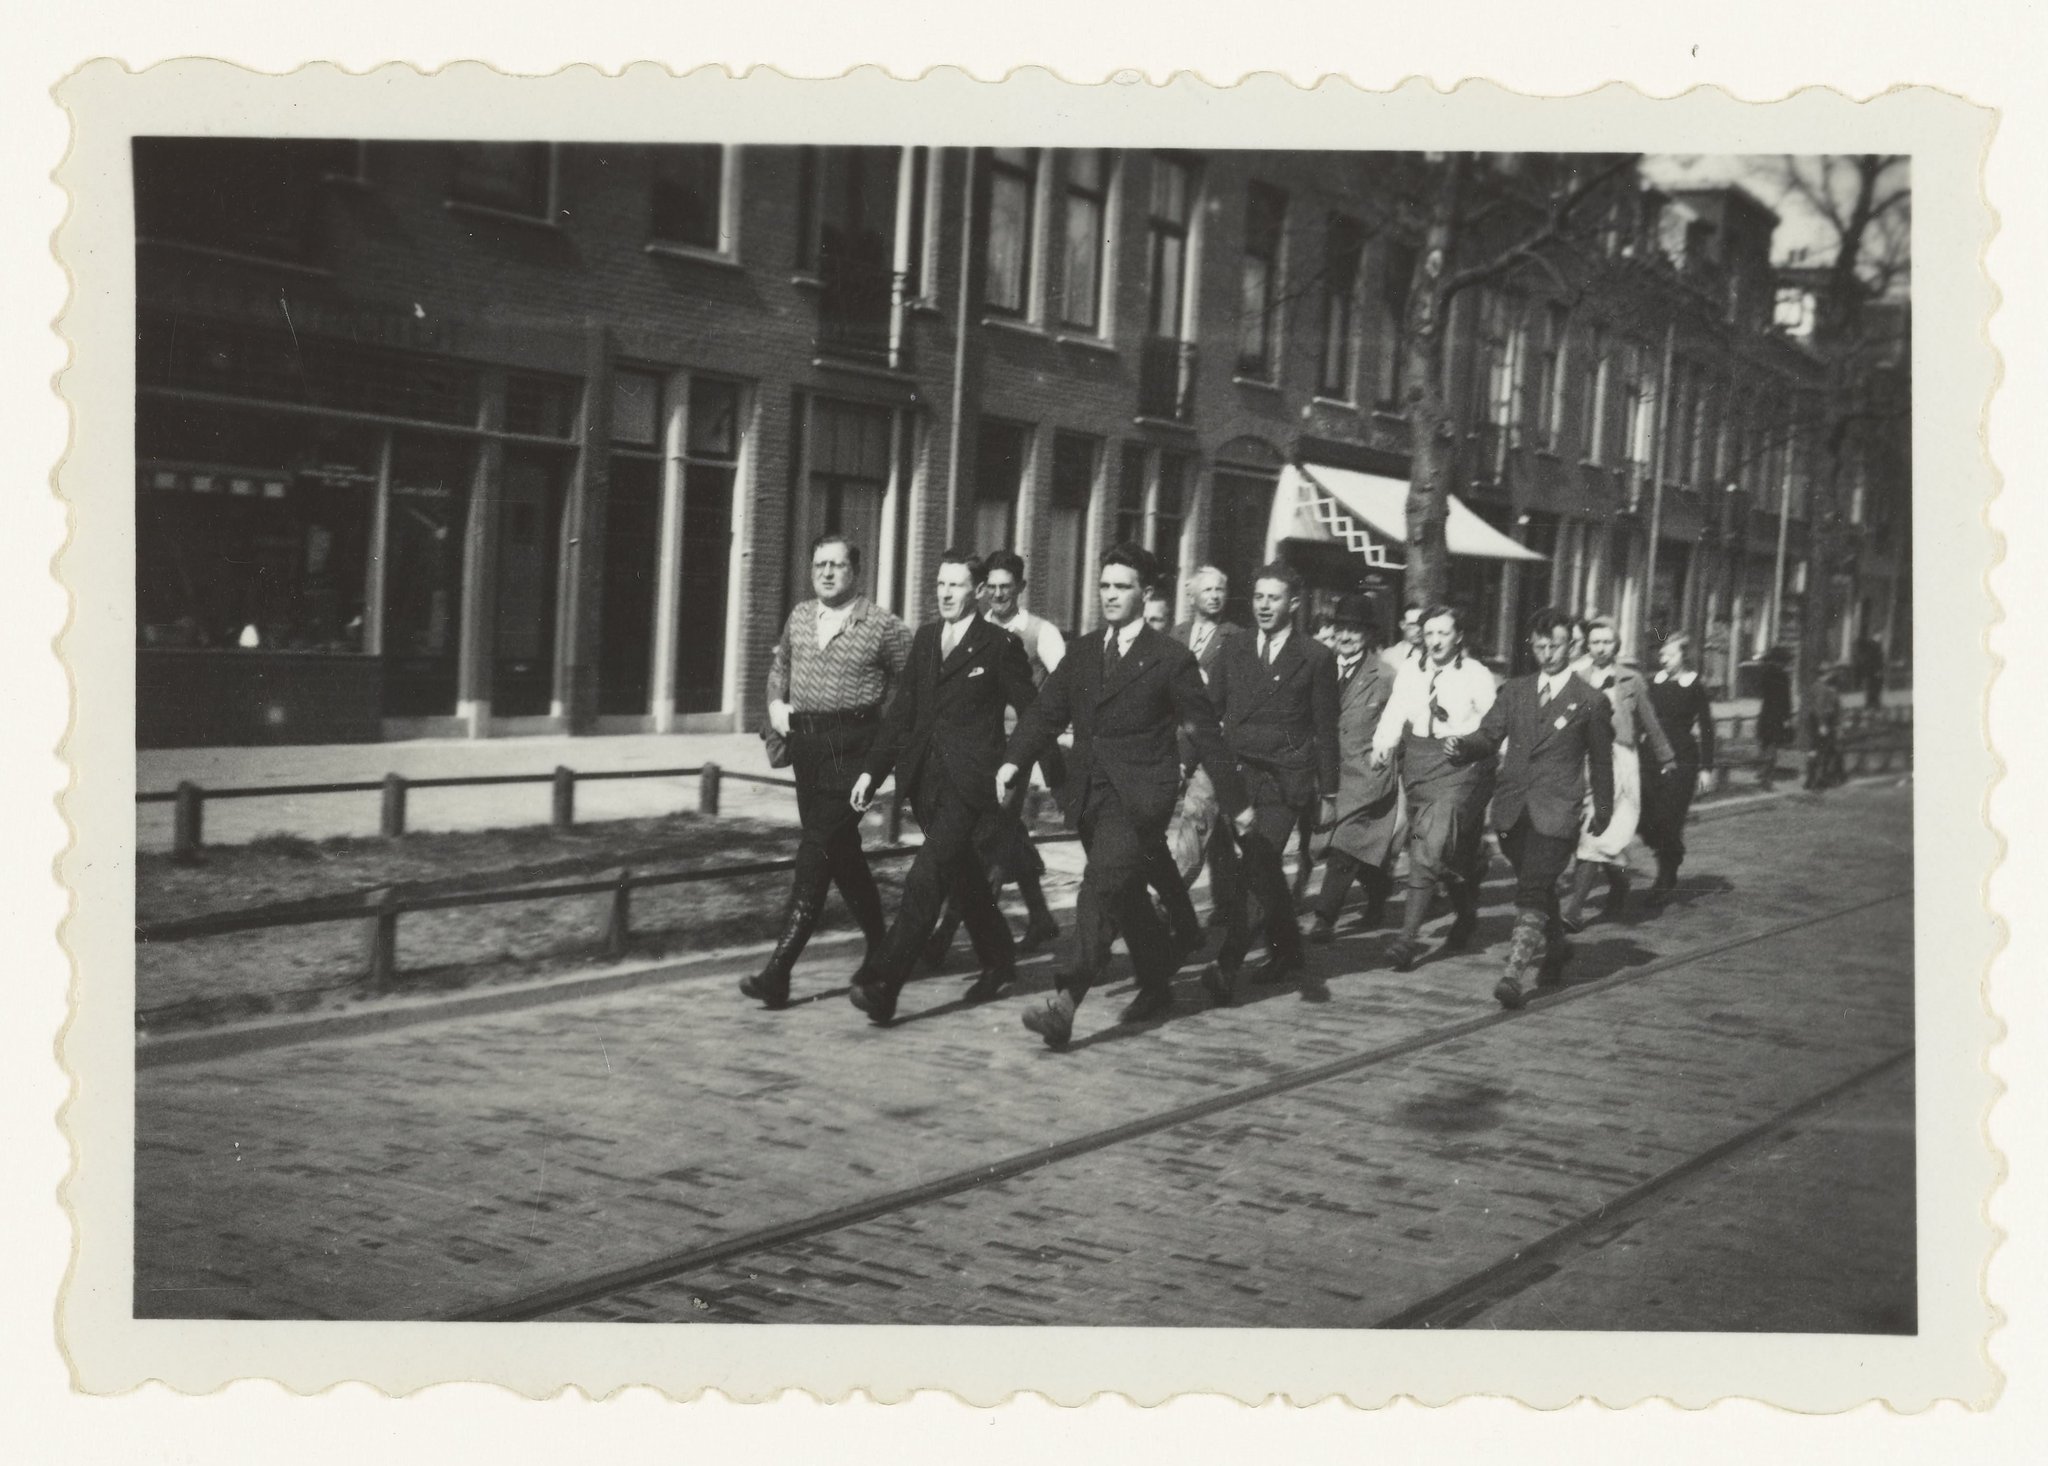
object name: photograph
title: Optocht NSB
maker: Anonymous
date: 1936-1937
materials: photographic support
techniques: gelatin silver print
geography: utrecht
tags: military parade, pageant, amsterdam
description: Optocht van de NSB. Voorop drie mannen waaronder de man in de geruite pullover. Niemand is in uniform, wel hebben sommigen hoge laarzen aan. Links een rij huizen. Vanaf 1936 gold voor de NSB en aan hen verwante organisaties een verbod om in uniform op straat te verschijnen.